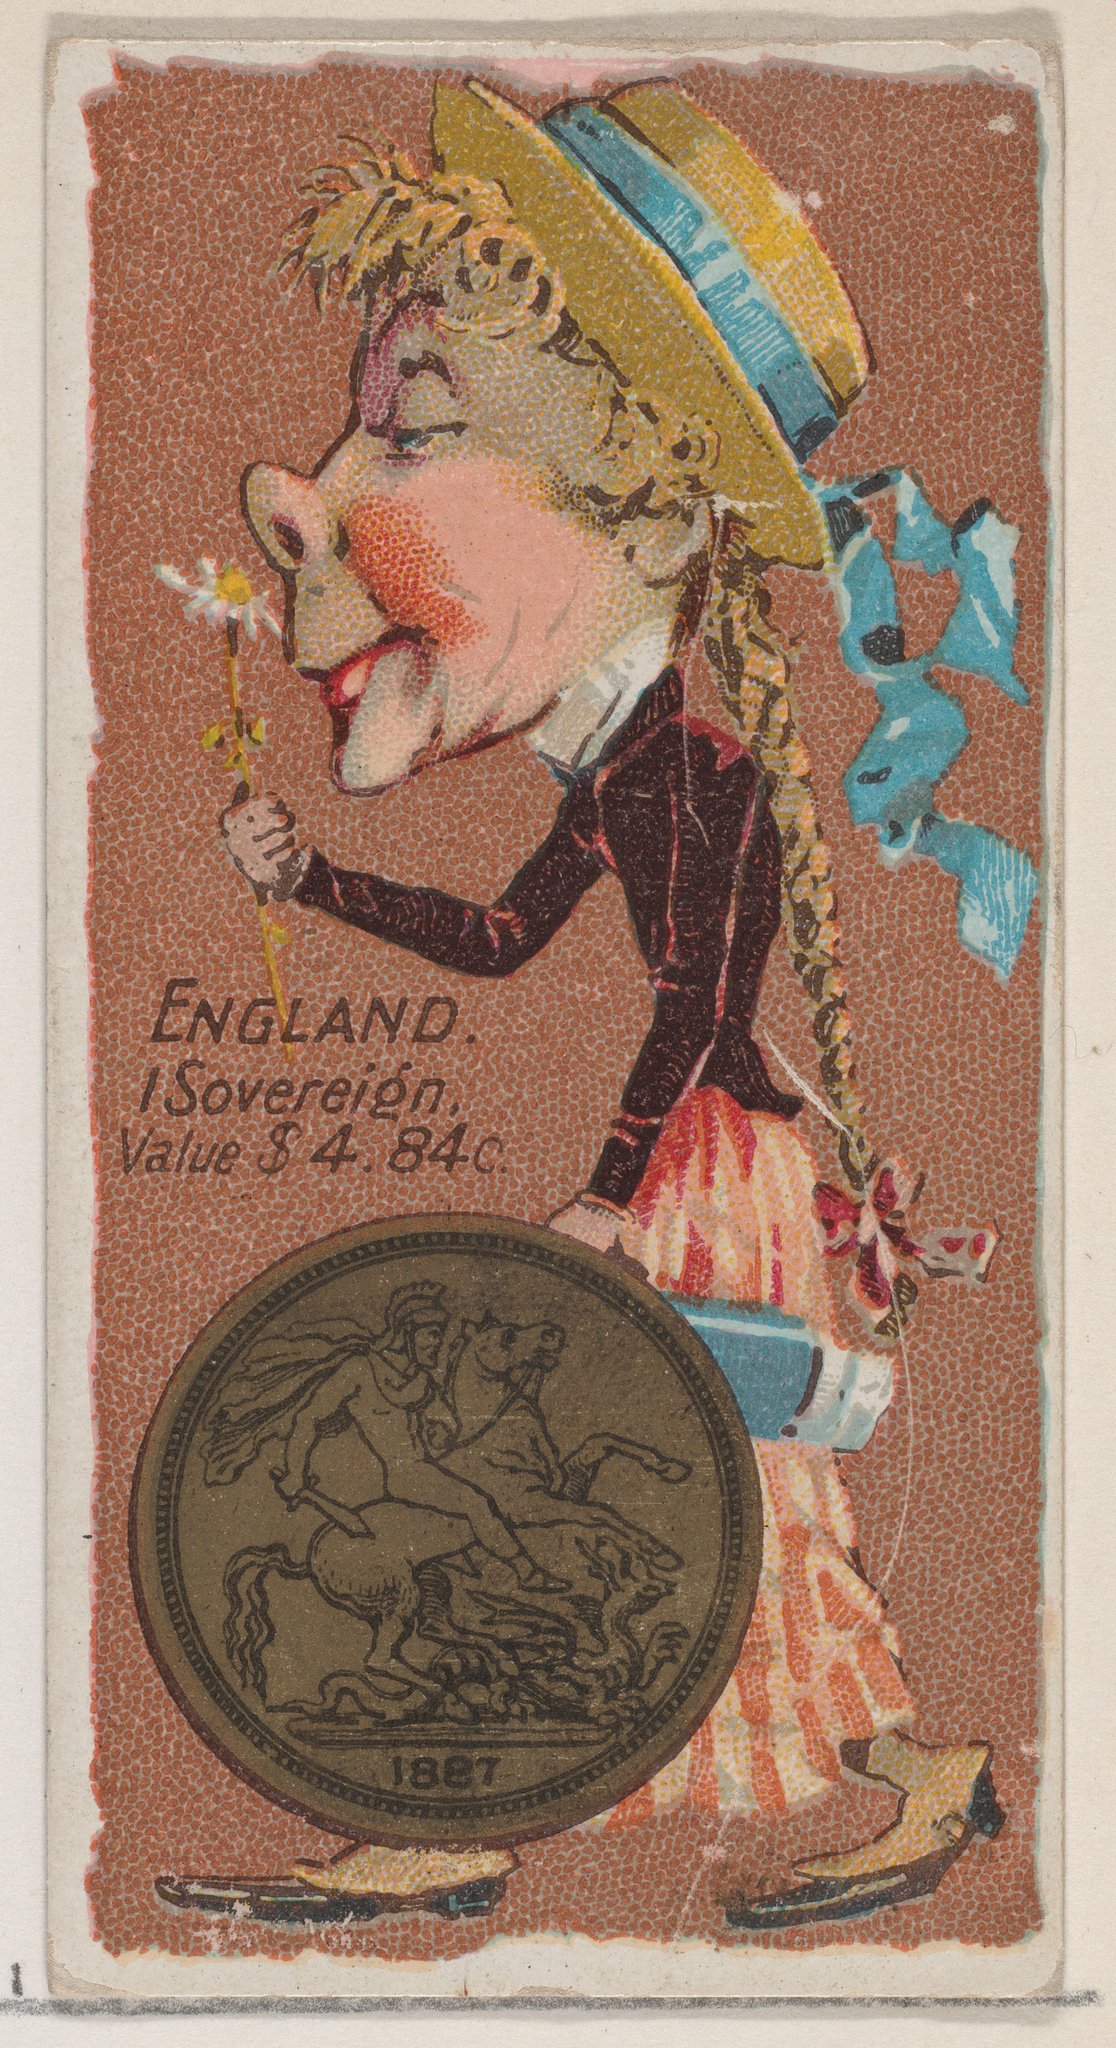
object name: print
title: England, 1 Sovereign, from the series Coins of All Nations (N72, variation 2) for Duke brand cigarettes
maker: w. duke, sons & co.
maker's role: publisher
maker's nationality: american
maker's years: 1870-1920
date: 1889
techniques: color lithograph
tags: women,coins